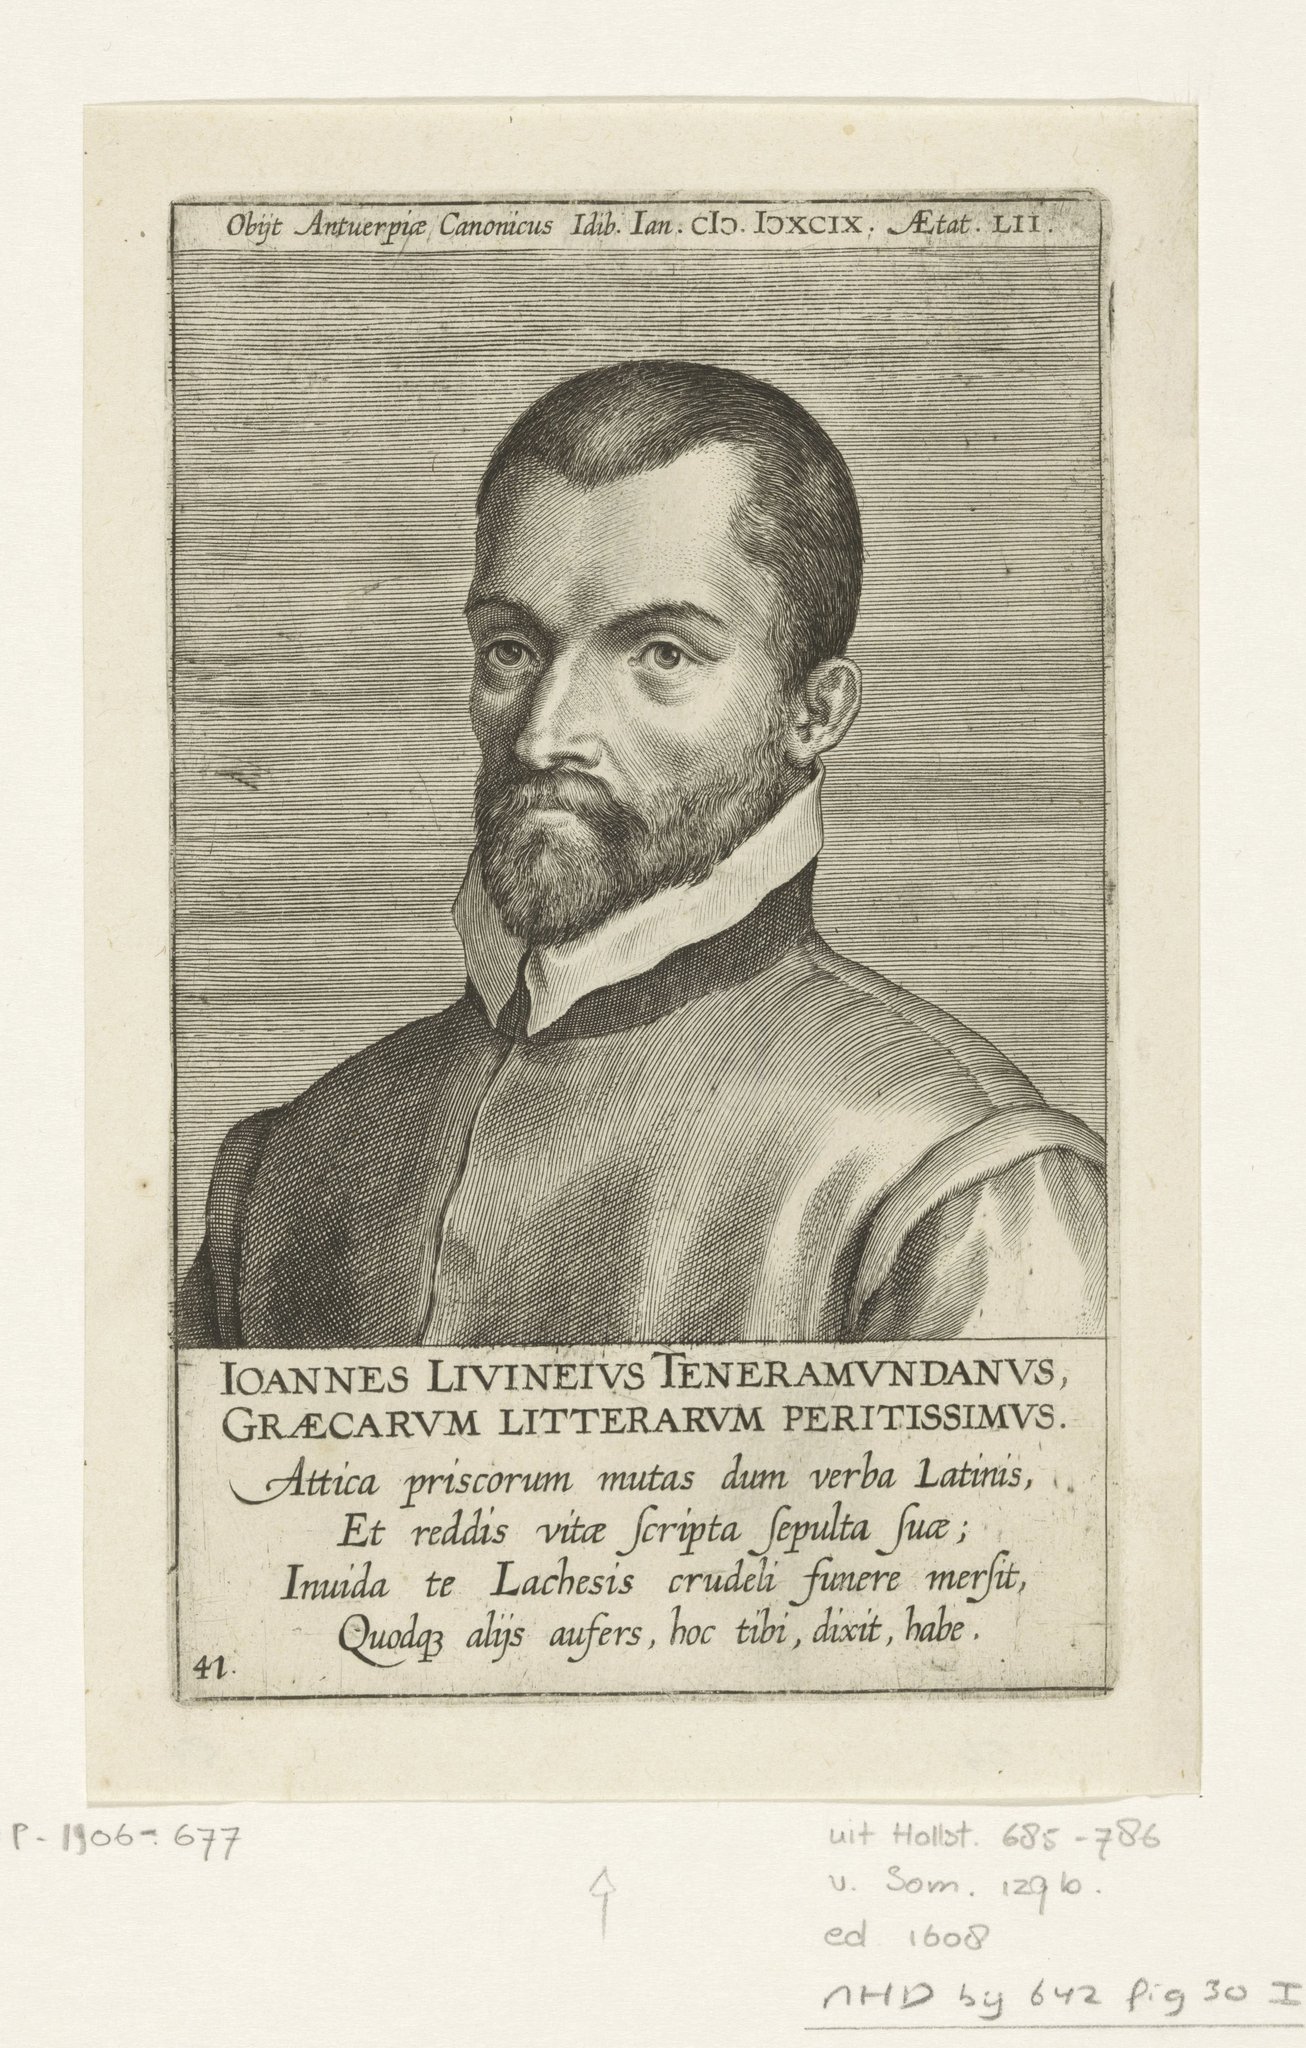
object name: print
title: Illustrium Galliae Belgicae scriptorum icones et elogi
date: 1604-1608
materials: paper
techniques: engraving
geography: antwerp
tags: leiden, amsterdam, painter, print maker, draughtsman, jan lievens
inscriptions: collector's mark: Lugt 2228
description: Portret van Jan Lievens, kanunnik van Antwerpen. Buste naar links. De prent heeft een Latijns boven- en onderschrift en maakt deel uit van een serie van beroemde Nederlandse en Vlaamse geleerden.